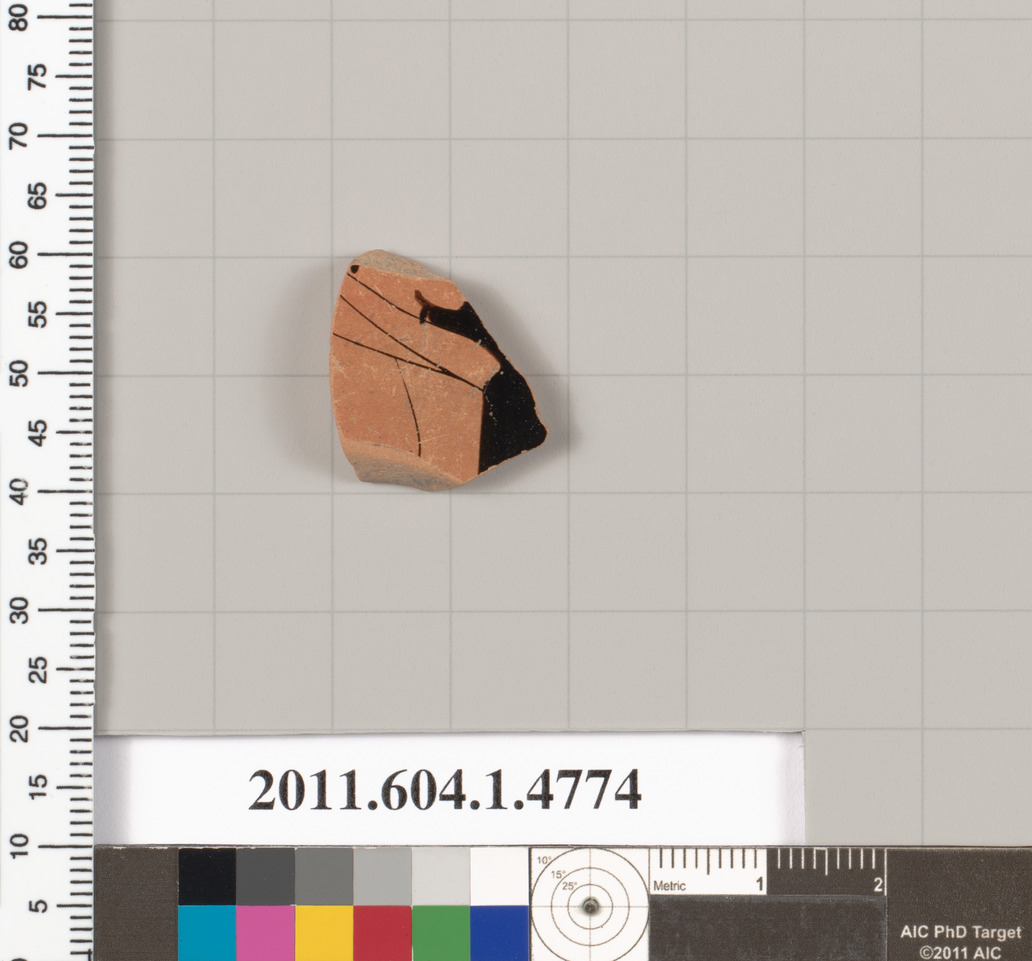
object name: kylix fragment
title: Terracotta fragment of a kylix (drinking cup)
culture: greek, attic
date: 475-451 BCE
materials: terracotta